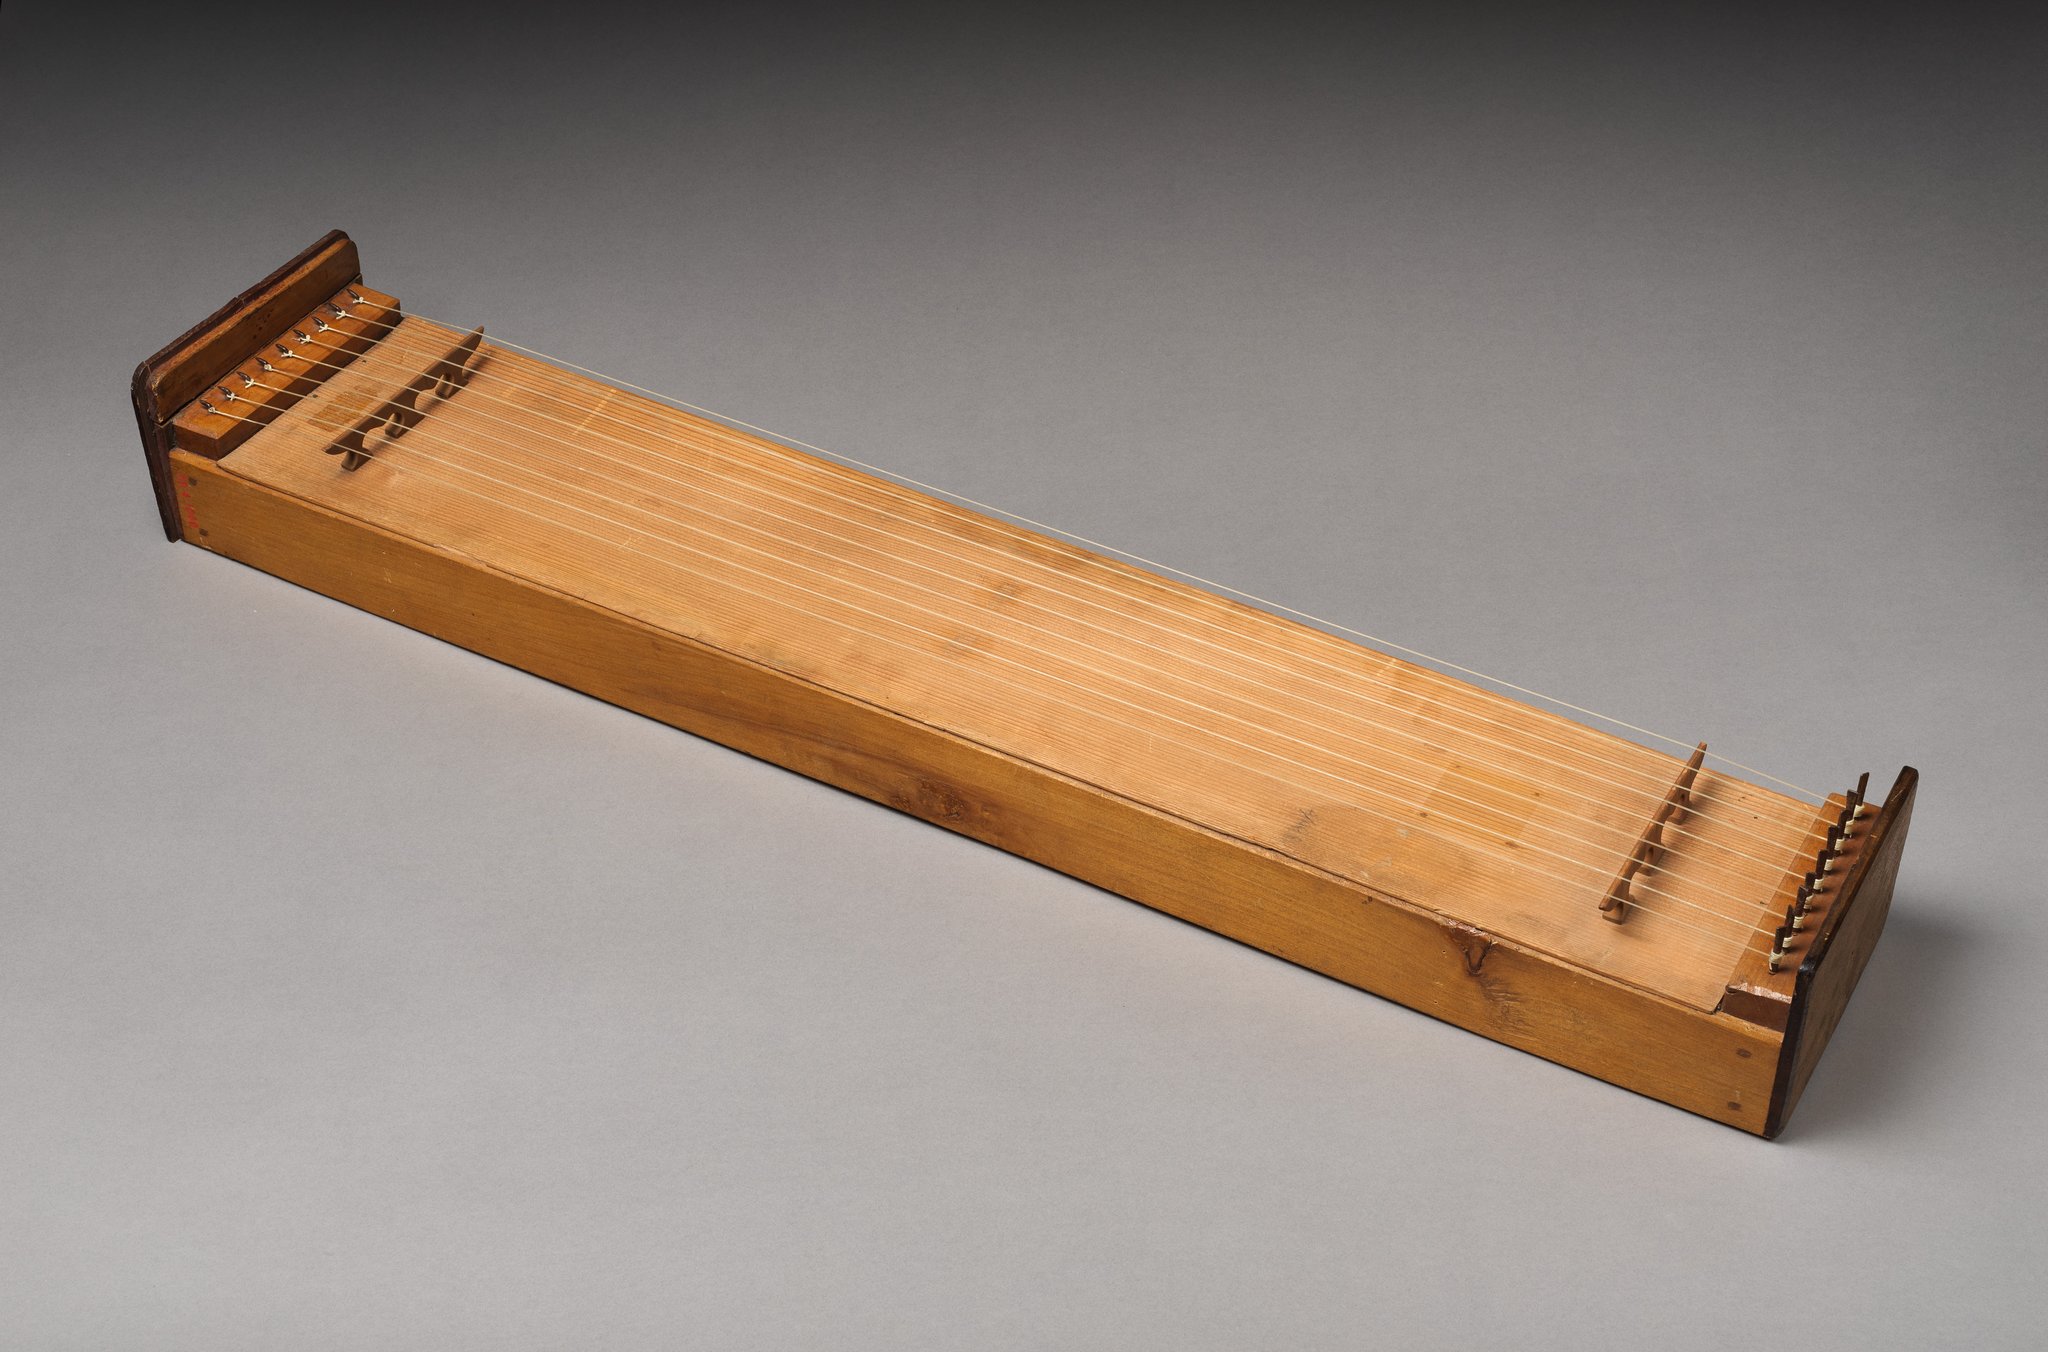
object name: aeolian harp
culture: british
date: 1801-1900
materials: wood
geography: united kingdom